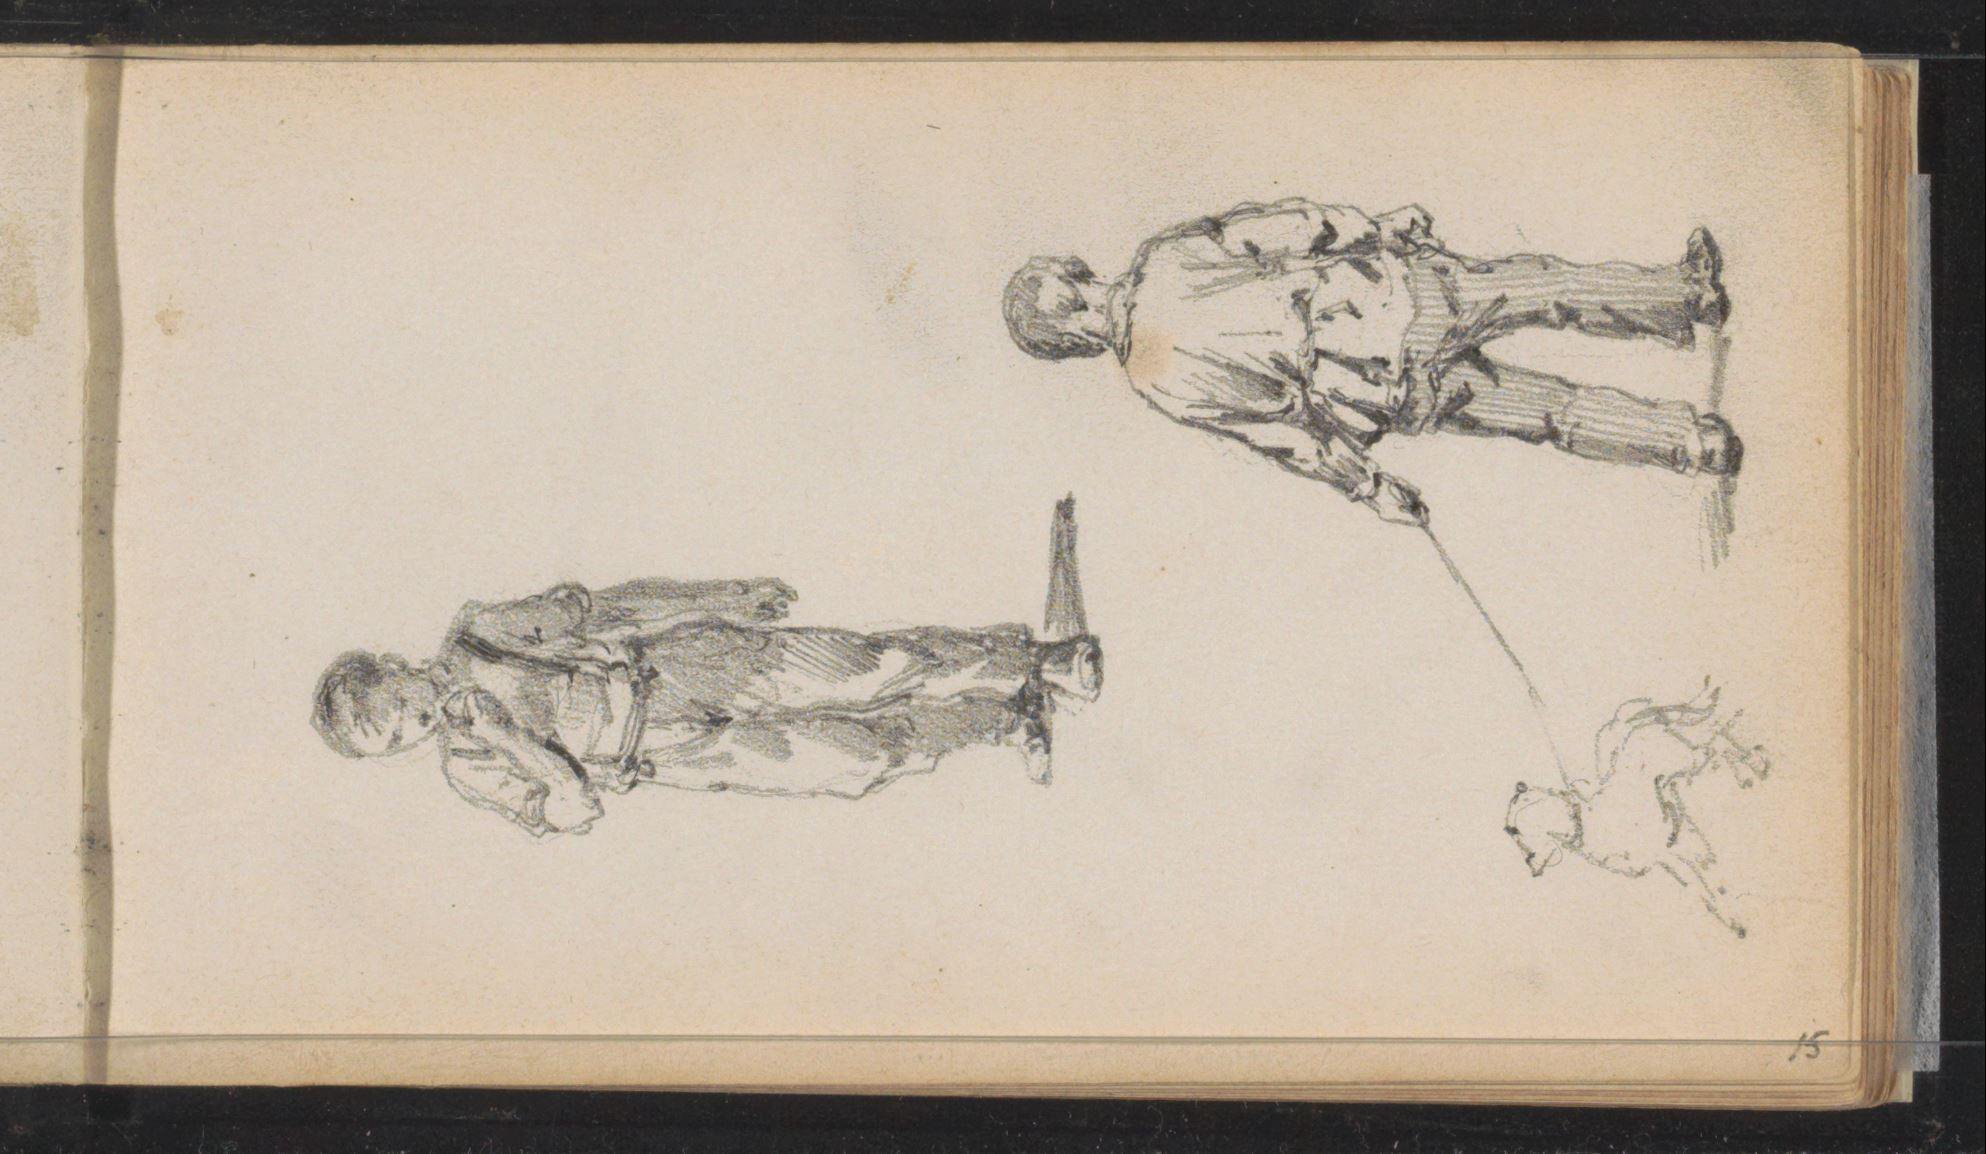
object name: sketchbook leaf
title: Twee jongens en een hond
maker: cornelis springer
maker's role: draughtsman, painter, print maker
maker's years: 1817-1891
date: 1860-1862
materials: paper, pencil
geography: netherlands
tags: boy (child between toddler and youth), dog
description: Boven een jongen, van voren gezien. Onder een jongen, op de rug gezien met een hond aan de lijn. Blad 15 uit een schetsboek met 44 bladen.